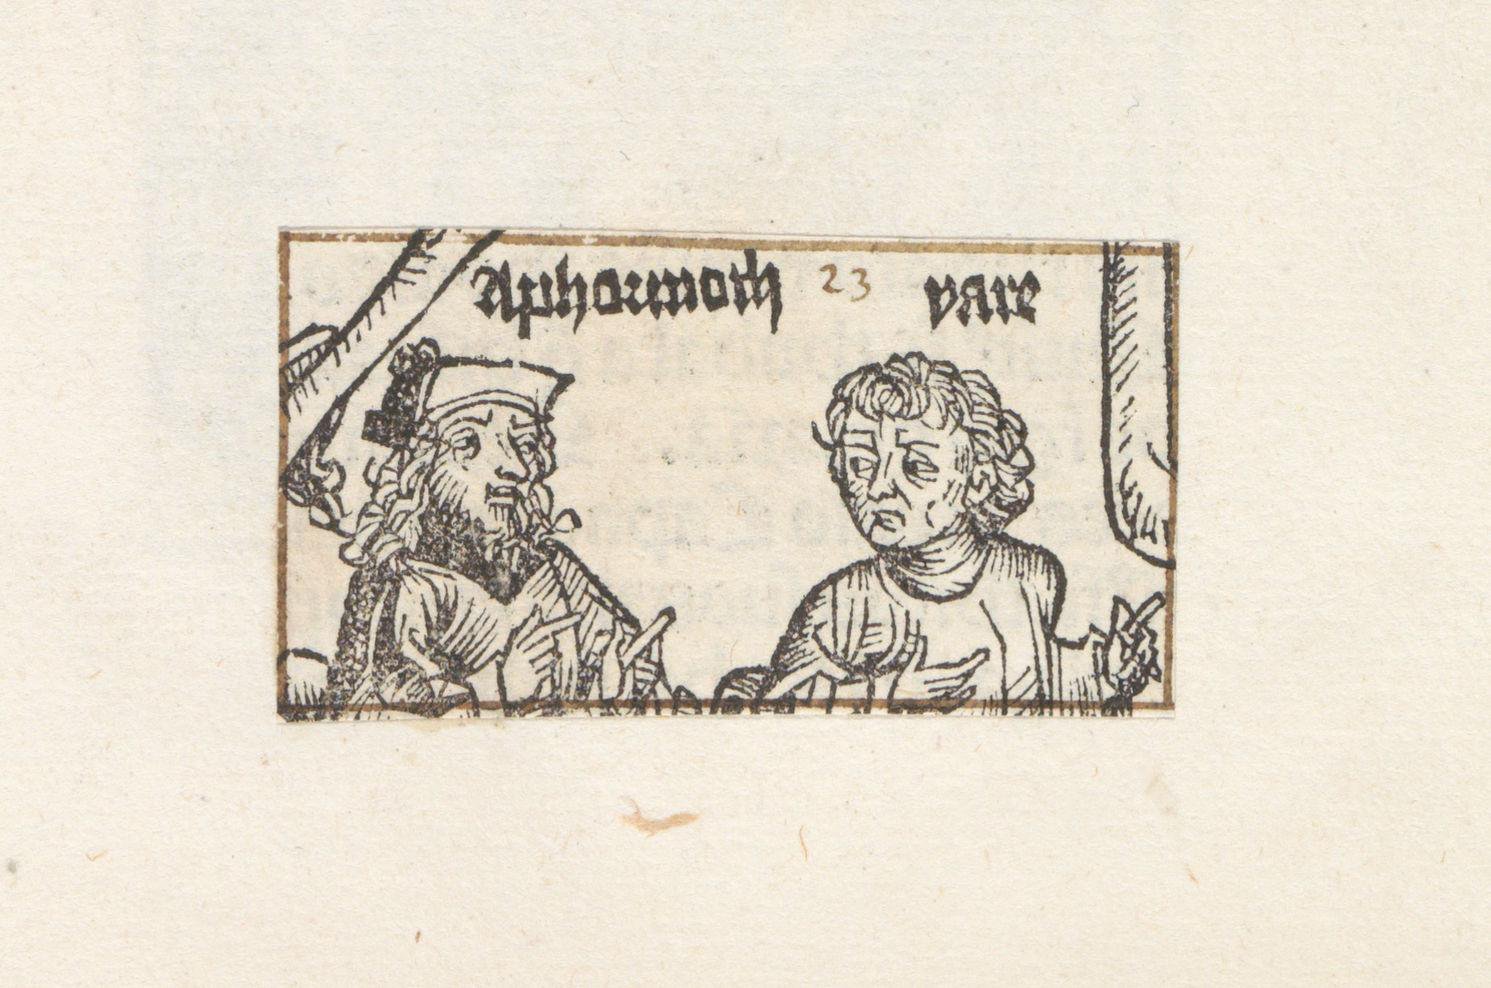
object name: book illustration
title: Liber Chronicarum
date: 1493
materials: paper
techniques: letterpress printing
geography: nuremberg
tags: persons from the old testament (not in biblical context, nor occurring in legendary/historical extensions included in division 71)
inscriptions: inscription: ‘23’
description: De houtsnede wordt gebruikt als boekillustratie in de Liber Chronicarum (of Neurenbergkroniek) van Hartmann Schedel, verschenen in het Latijn en Duits in 1493. Zie de Latijnse uitgave, folio 16v.